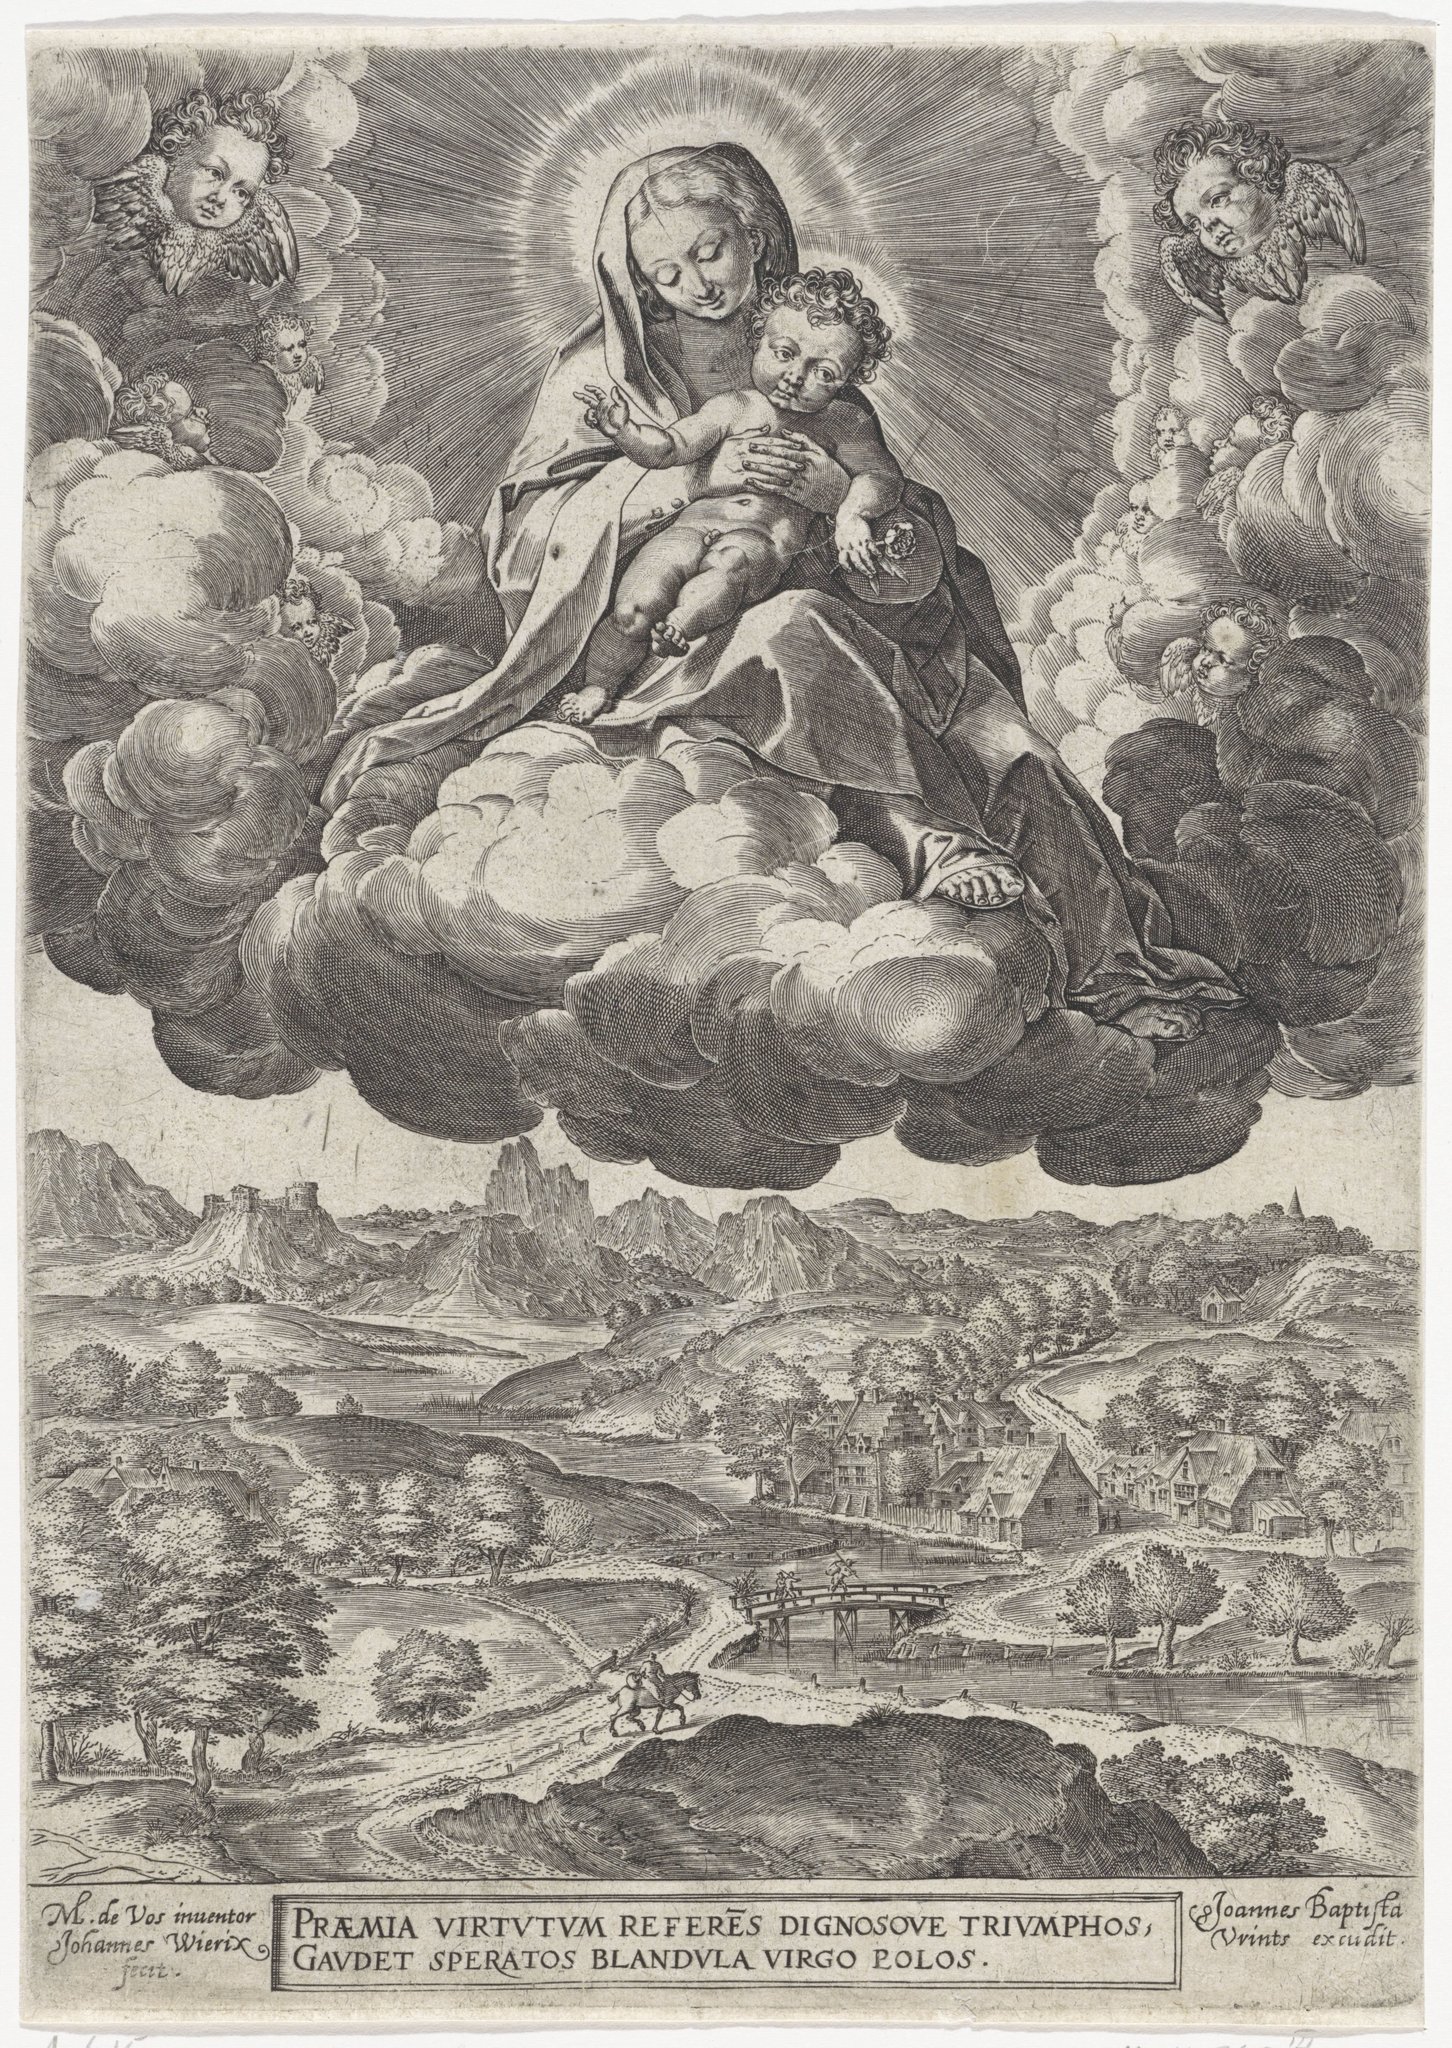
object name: print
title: Maria met het Christuskind op de wolken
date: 1584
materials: paper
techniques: engraving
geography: antwerp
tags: mary (standing) with the christ-child in front of her (free-standing); christ-child lying (+ angel(s)), landscapes in the temperate zone, flowers: rose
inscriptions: inscription: ‘[...] 487/2’, collector's mark: Lugt 2228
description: Maria houdt het Christuskind met gevouwen handen vast op haar schoot. Het Kind heeft een roos in de hand en maakt een zegenend gebaar. Ze zitten op de wolken, omringd door cherubijnen. Onder hen een heuvelachtig landschap met een gezicht op een dorp langs een rivier. In het kader in de marge een tweeregelig onderschrift in het Latijn.